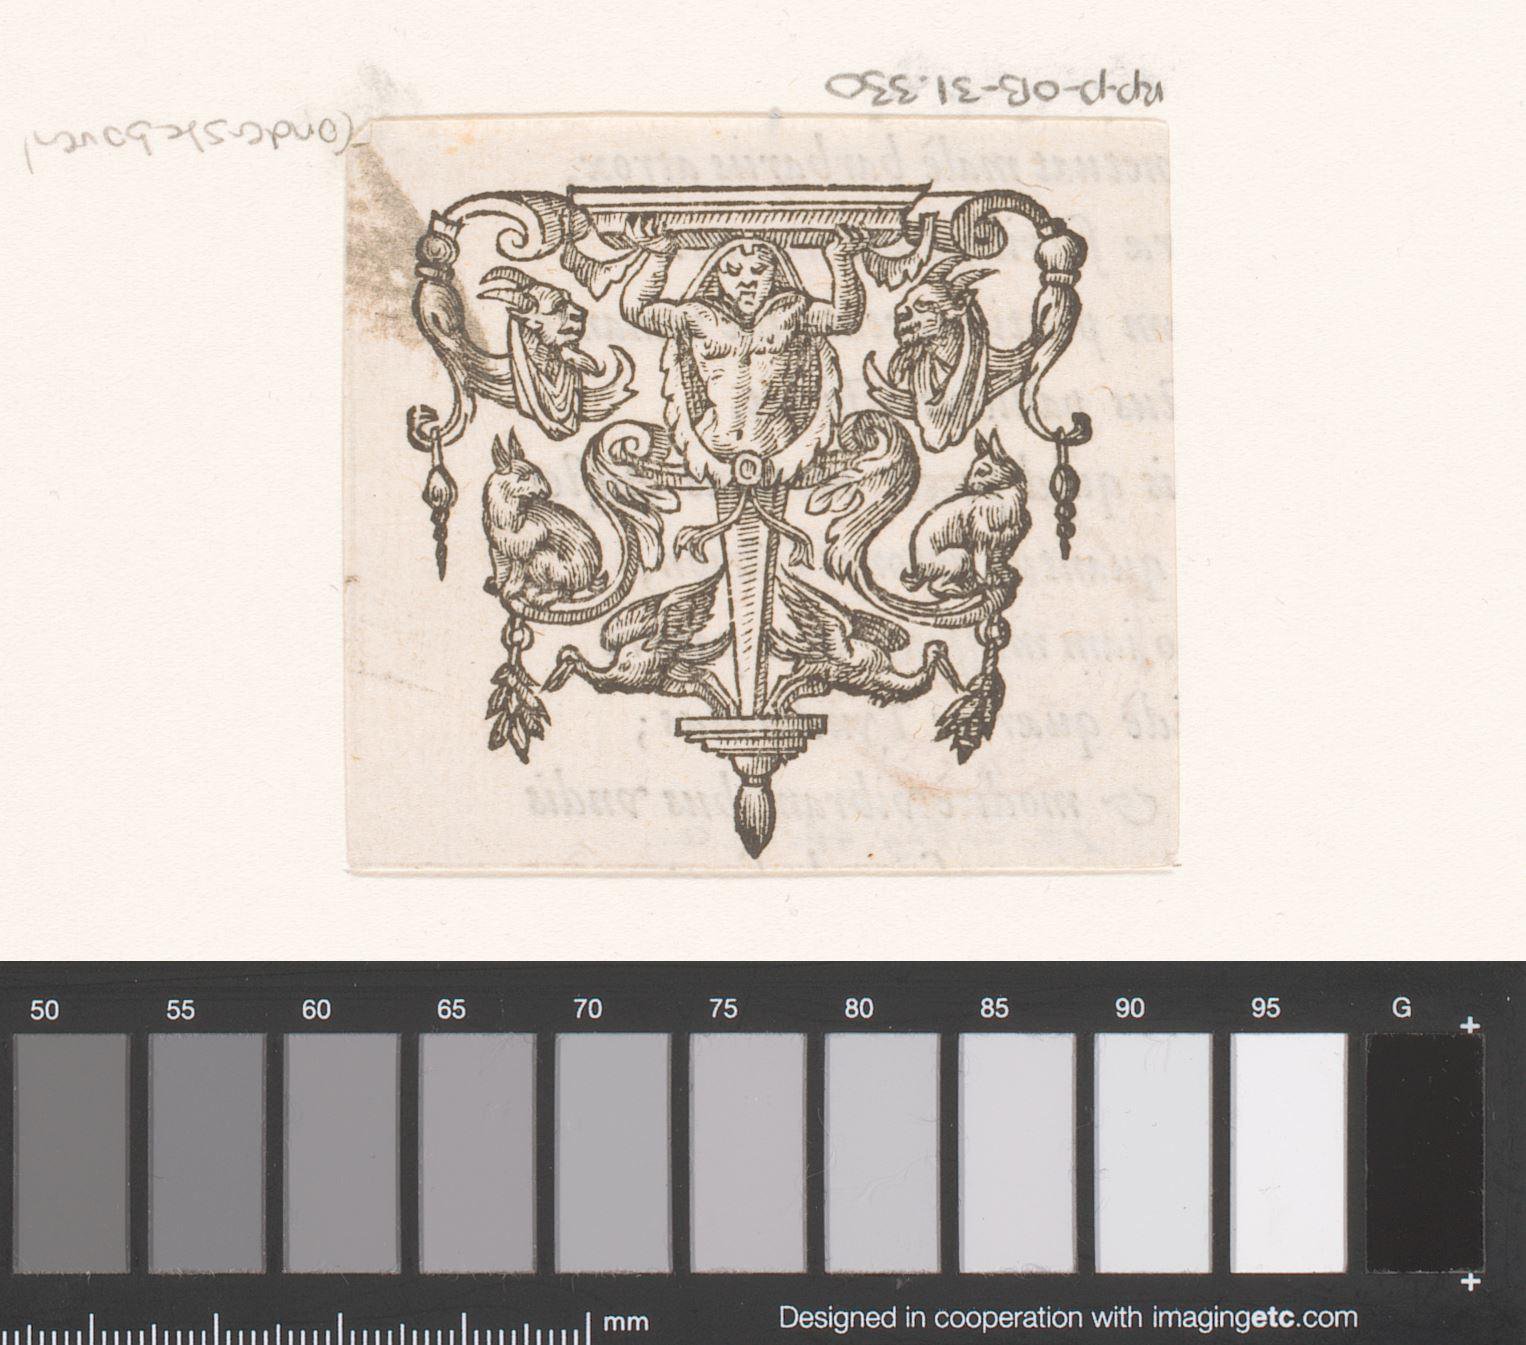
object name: book illustration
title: Allegorisch figuur een object dragend te midden van verschillende diersoorten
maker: Anonymous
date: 1600-1699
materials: paper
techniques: letterpress printing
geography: netherlands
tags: animals, adult man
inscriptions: collector's mark: Lugt 240